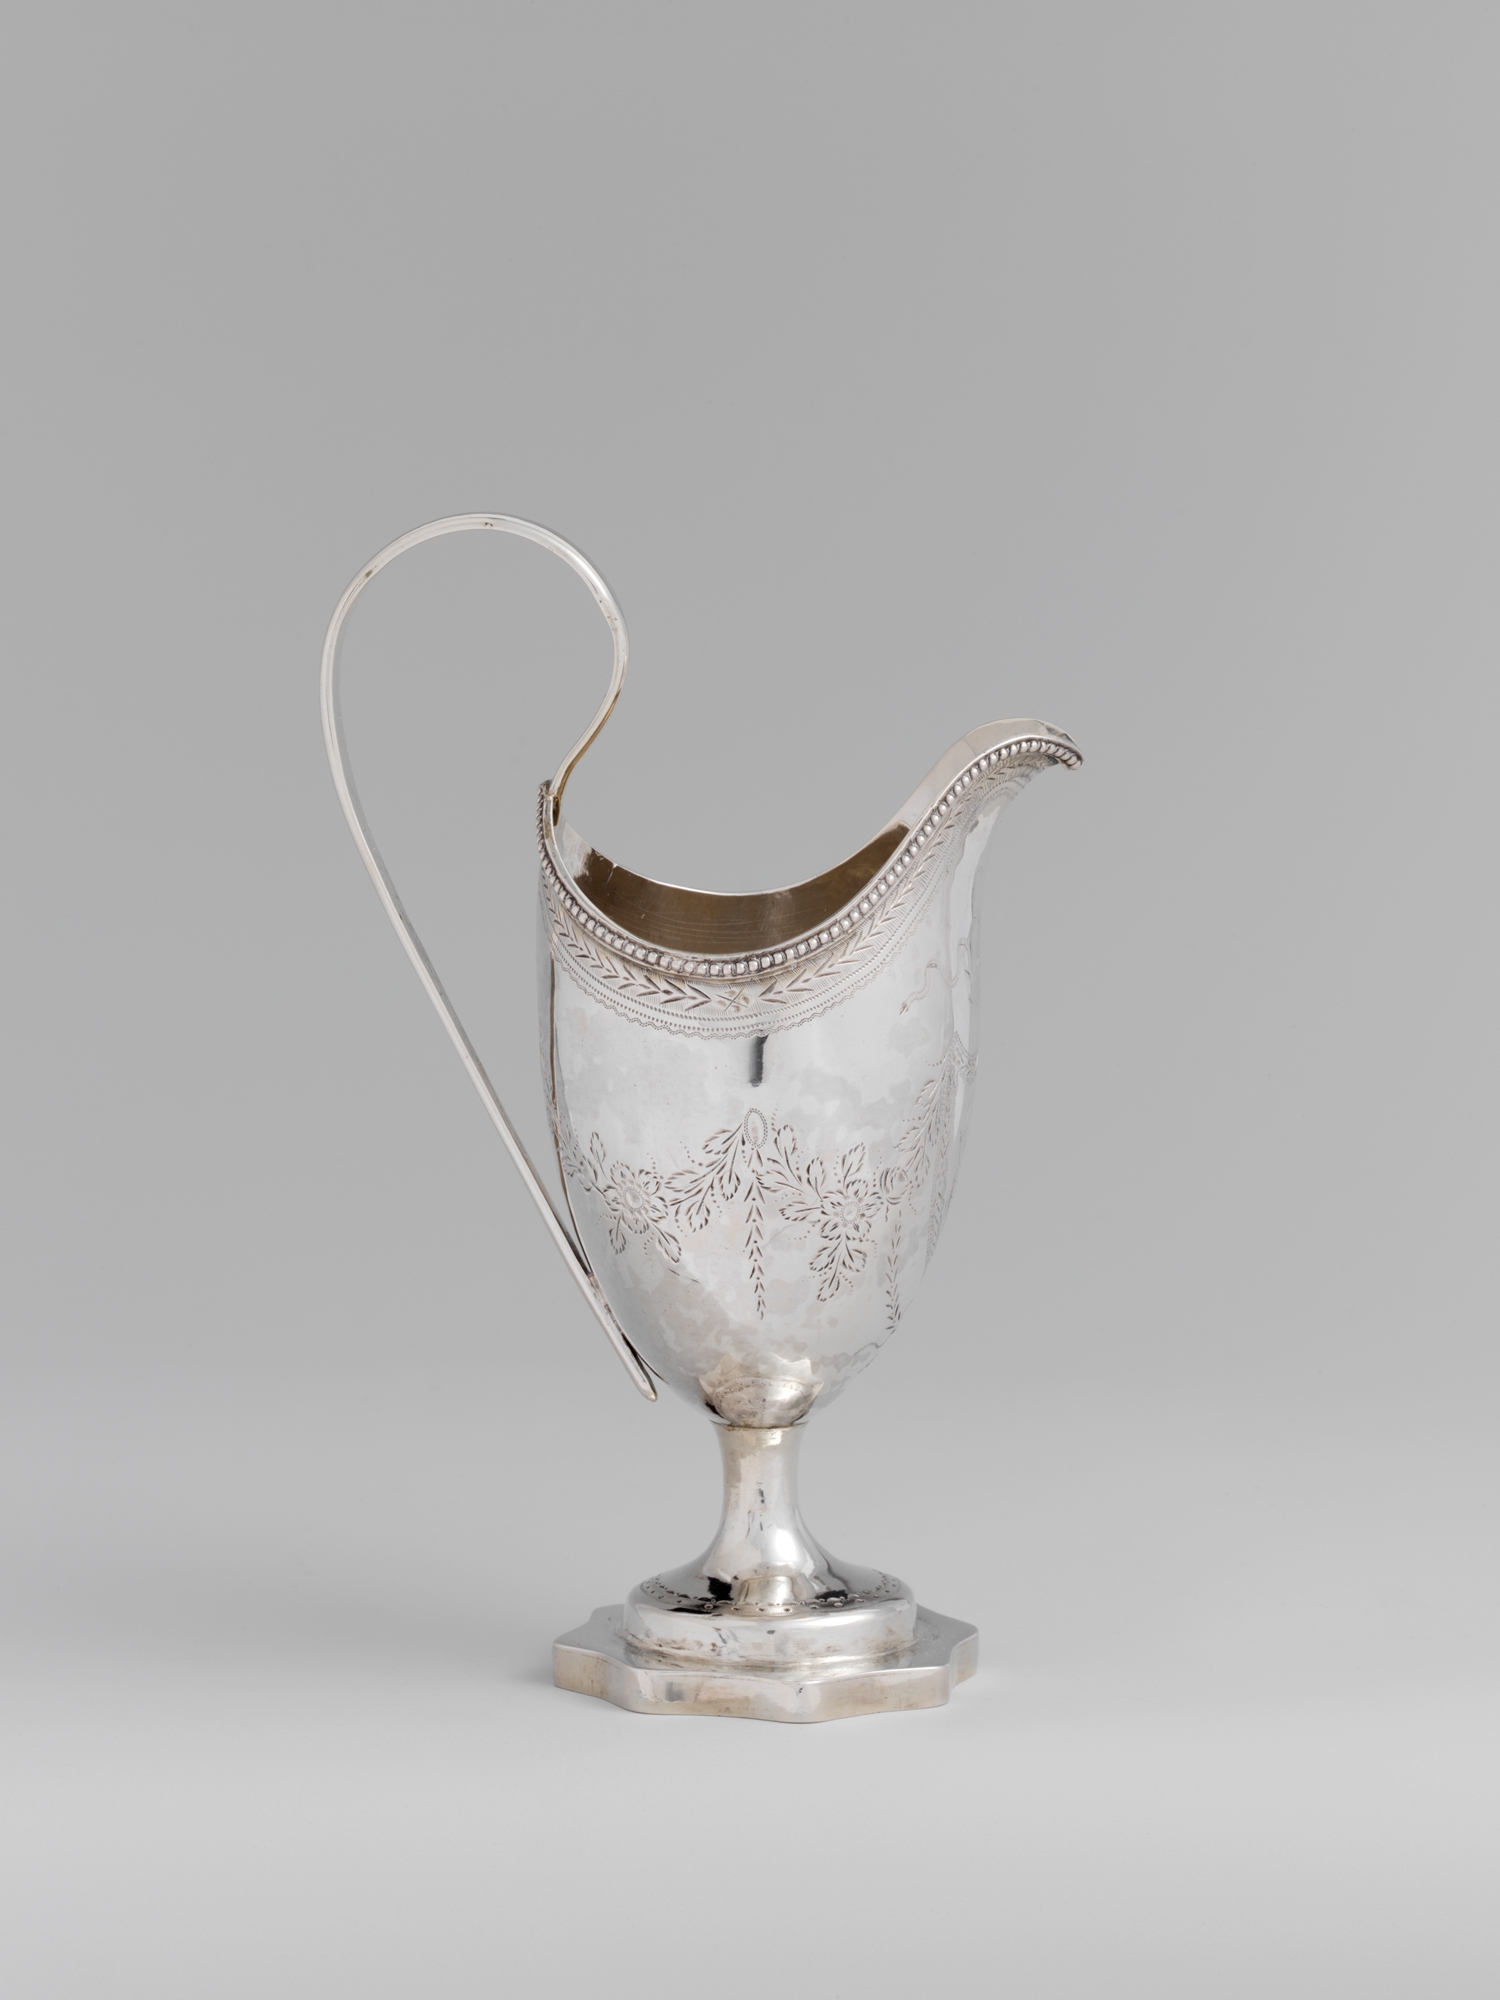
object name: cream pot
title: Creampot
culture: american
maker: william w. gilbert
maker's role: maker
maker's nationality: american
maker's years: 1746-1832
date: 1790-1800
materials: silver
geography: united states